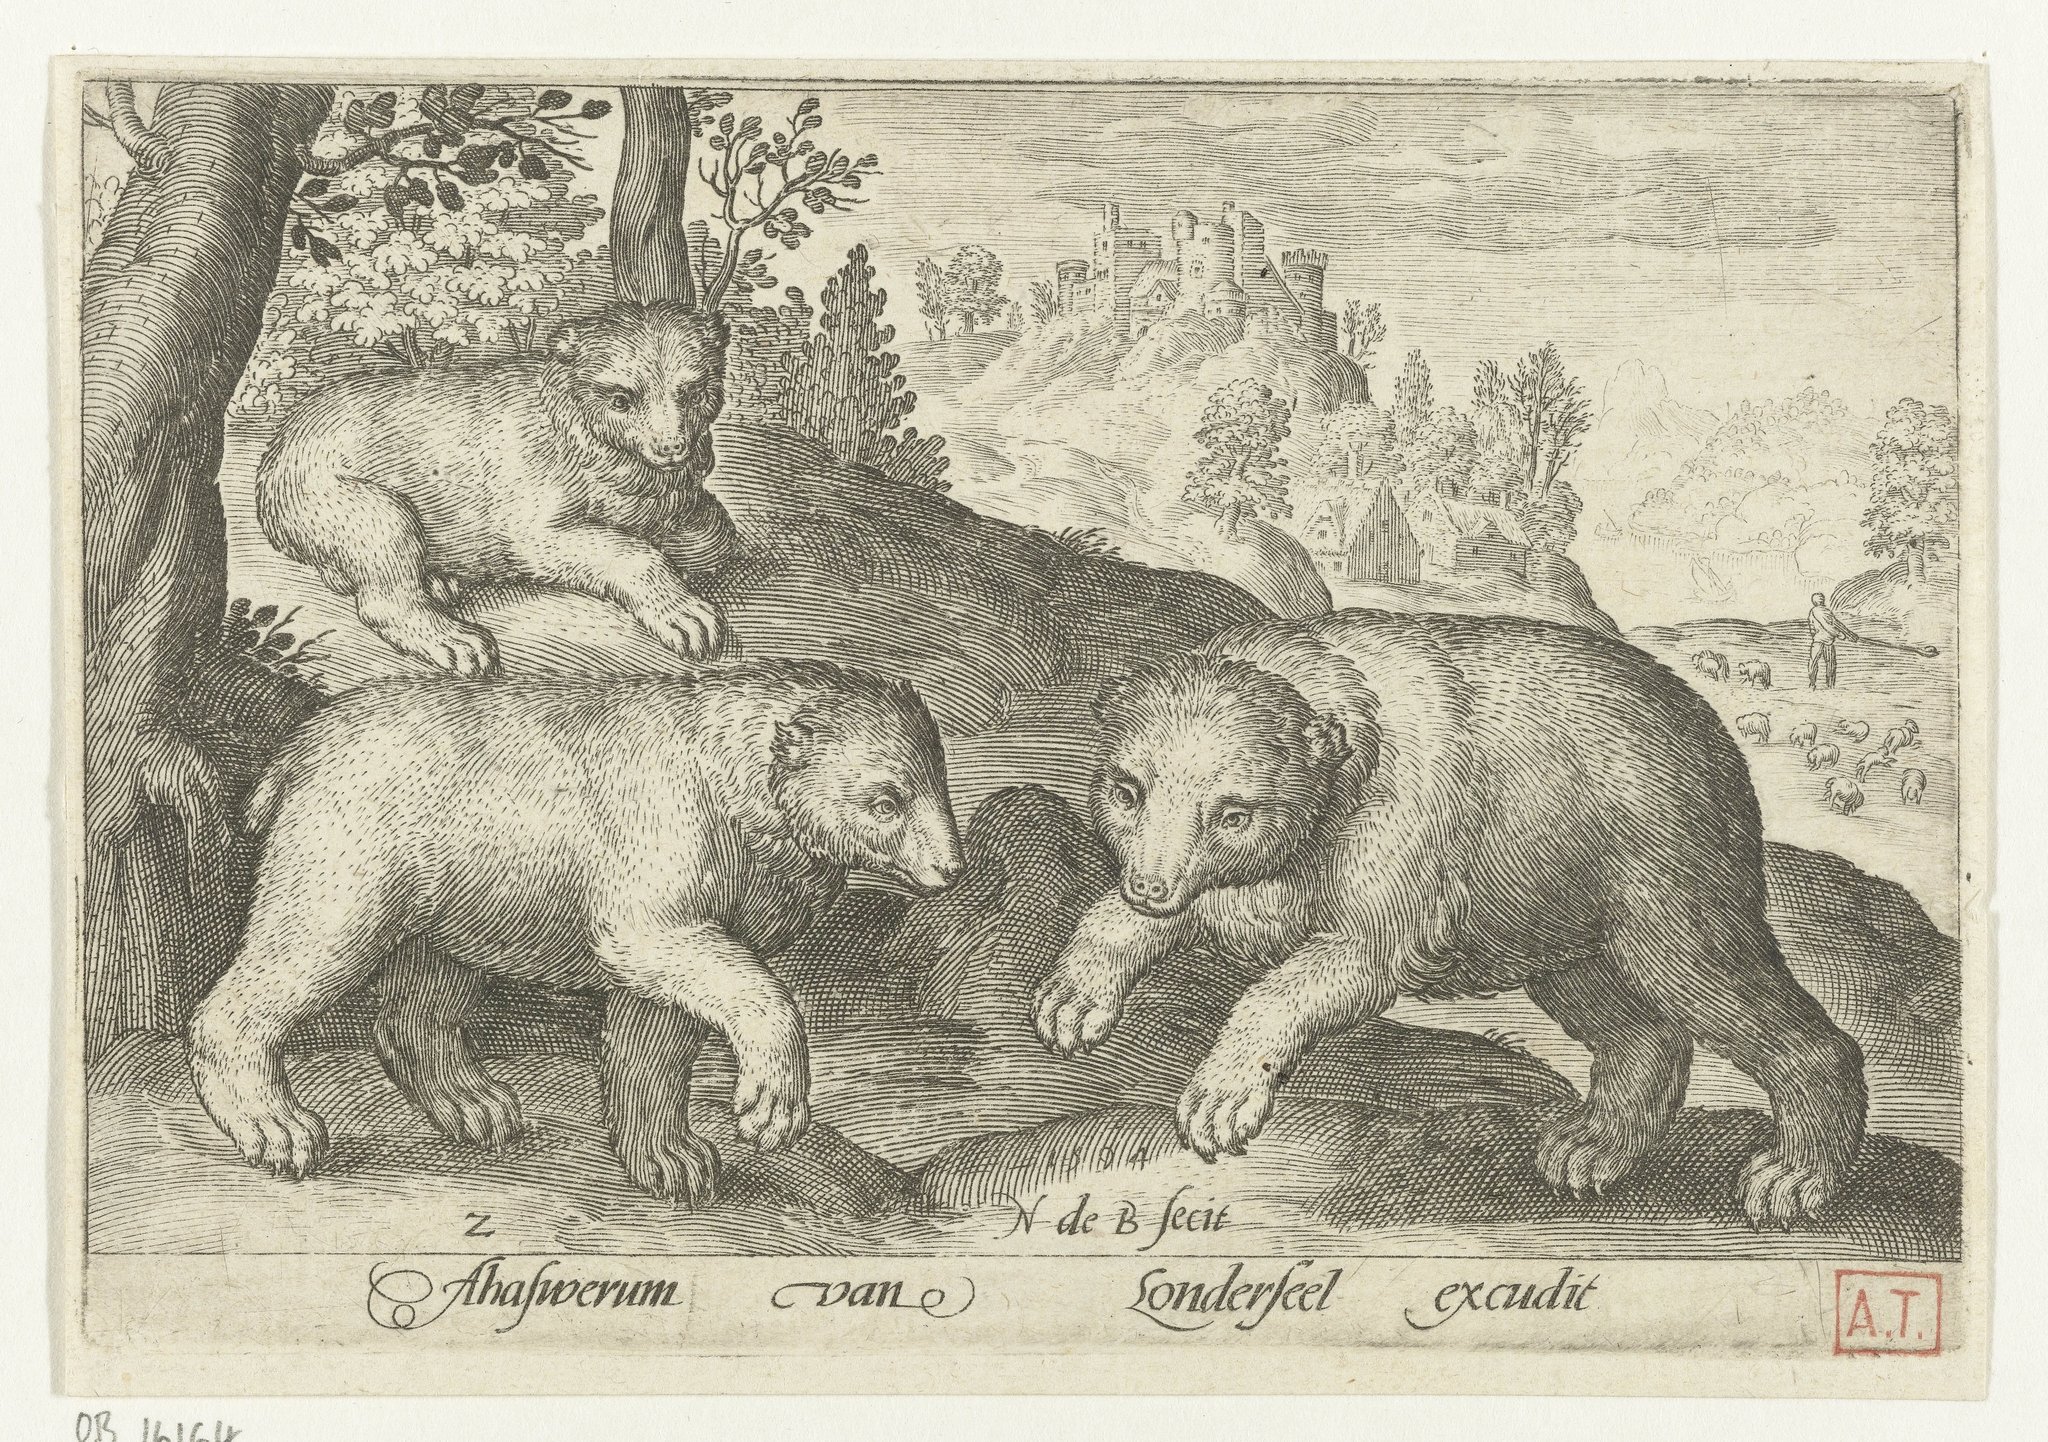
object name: print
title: Animalivm qvadrvpedvm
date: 1594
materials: paper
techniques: engraving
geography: antwerp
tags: beasts of prey, predatory animals: bear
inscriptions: collector's mark: Lugt 2228, collector's mark: Lugt 184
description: Prent uit serie Animalivm qvadrvpedvm van twaalf prenten met dieren (viervoeters) in landschappen. Hollstein beschrijft twee staten, als eerste staat een uitgave van Assuerus van Londerseel voor de nummering (gedateerd 1594) en als tweede staat een uitgave van Claes Jansz. Visscher (II) met nummering (gedateerd 1621). Er is echter nog een andere editie bekend van uitgever Christoffel van Sichem welke tussen deze twee staten in geplaatst kan worden. Verschillende drukken van Visscher vertonen nog sporen van een adres van Van Sichem, op een enkel blad in de collectie van het RMA staat zijn adres, vergelijk RP-P-OB-16.158. De editie van Visscher is gedrukt van zeer versleten platen, zie De Groot 1988, p. 36, 37.